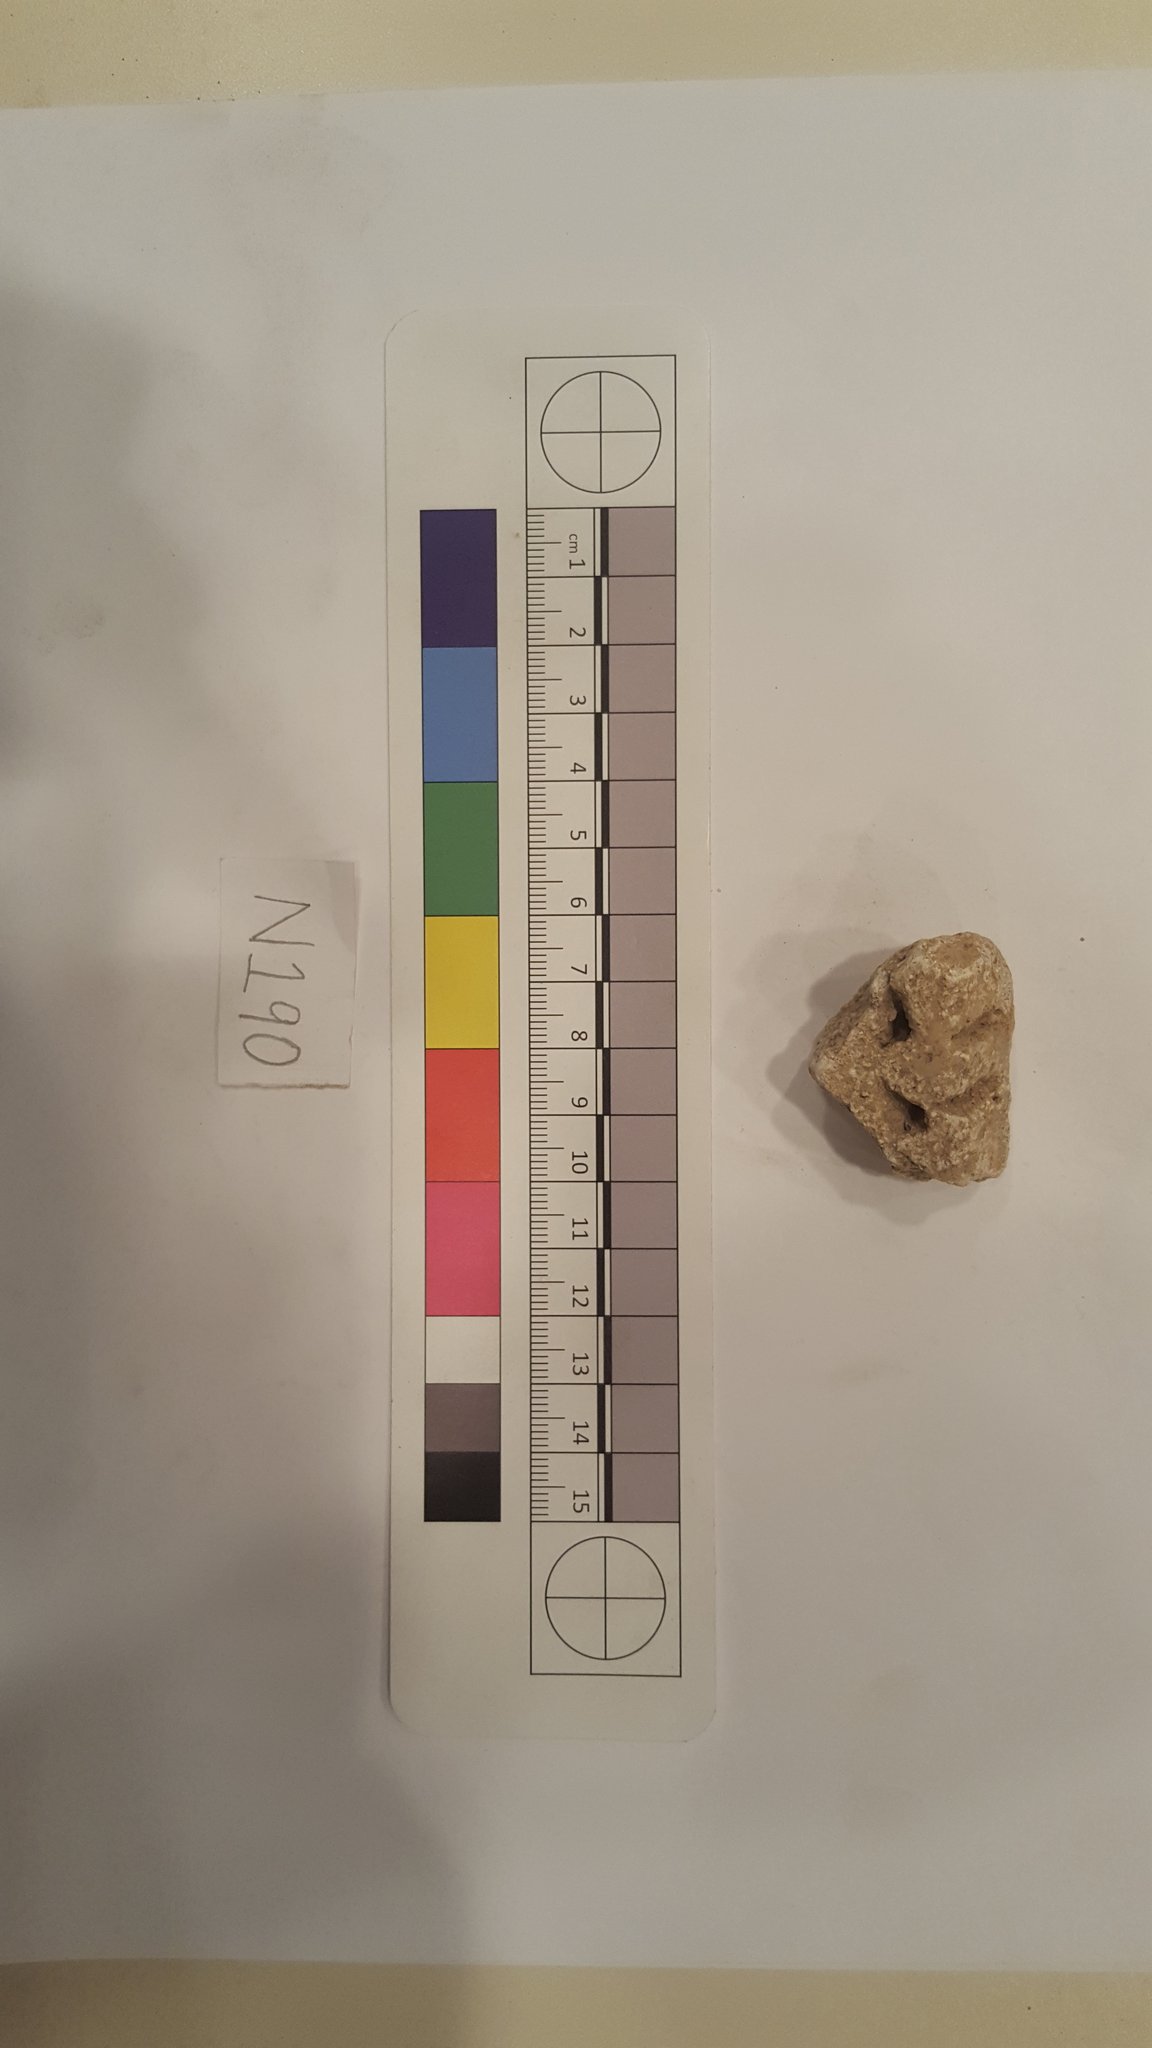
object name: fragment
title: Stucco Fragment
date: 701-1200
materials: plaster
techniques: carving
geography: iran